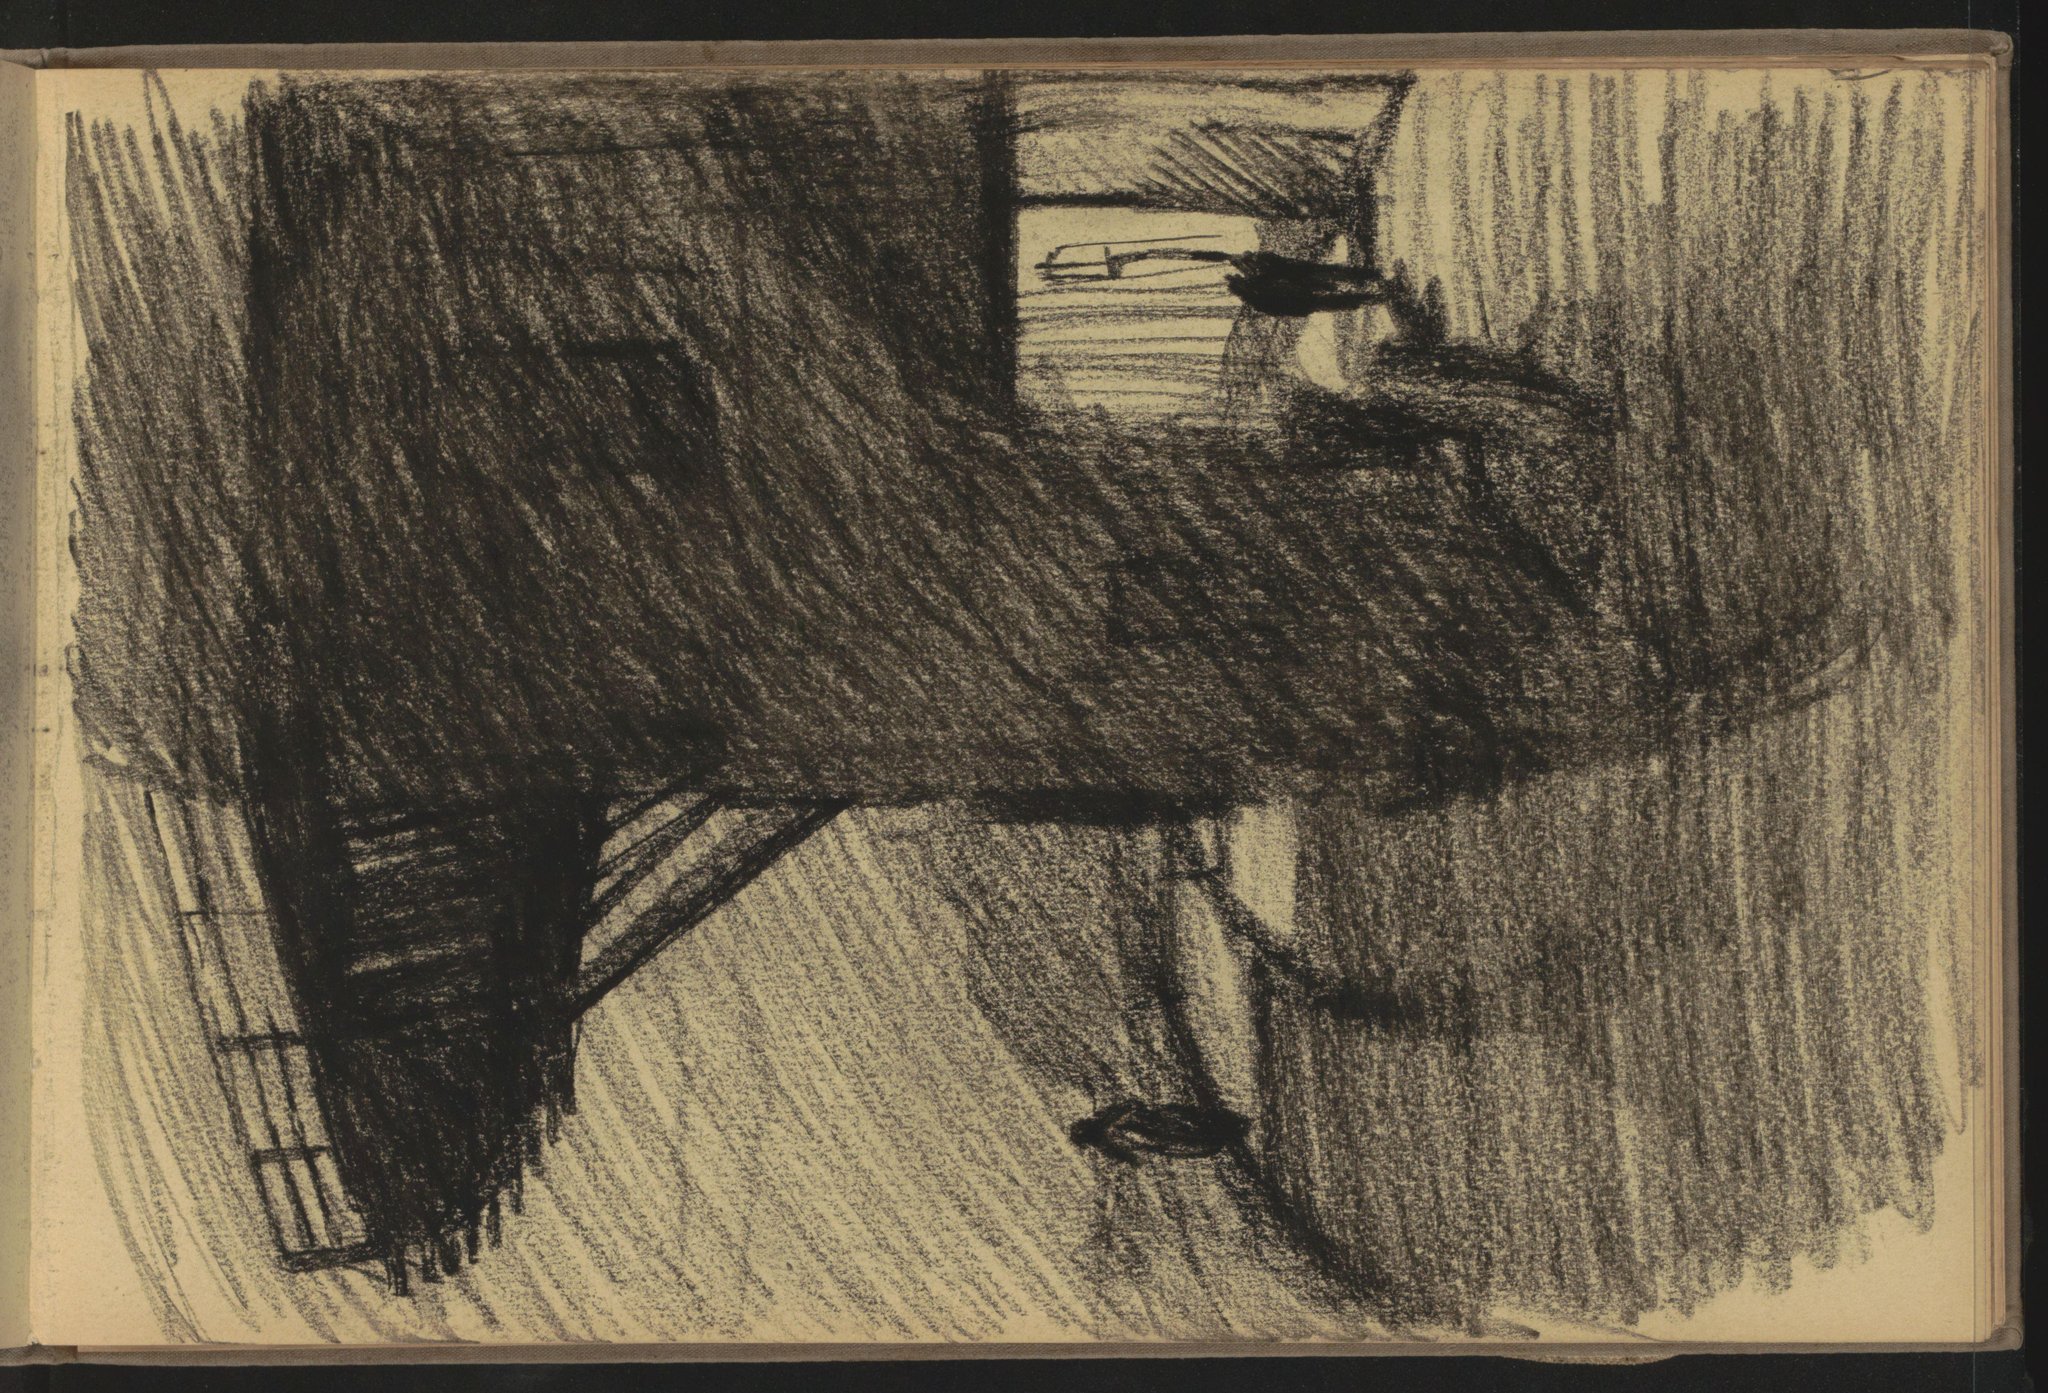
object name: sketchbook leaf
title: Gezicht op de poort van de molen Rijn en Lek te Wijk bij Duurstede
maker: willem witsen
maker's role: draughtsman, painter, print maker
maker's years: 1860-1923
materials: chalk, paper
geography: wijk bij duurstede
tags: windmill, street, city-gate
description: Voorstudie voor de ets 'Molenpoort, Wijk bij Duurstede', ca. 1908.